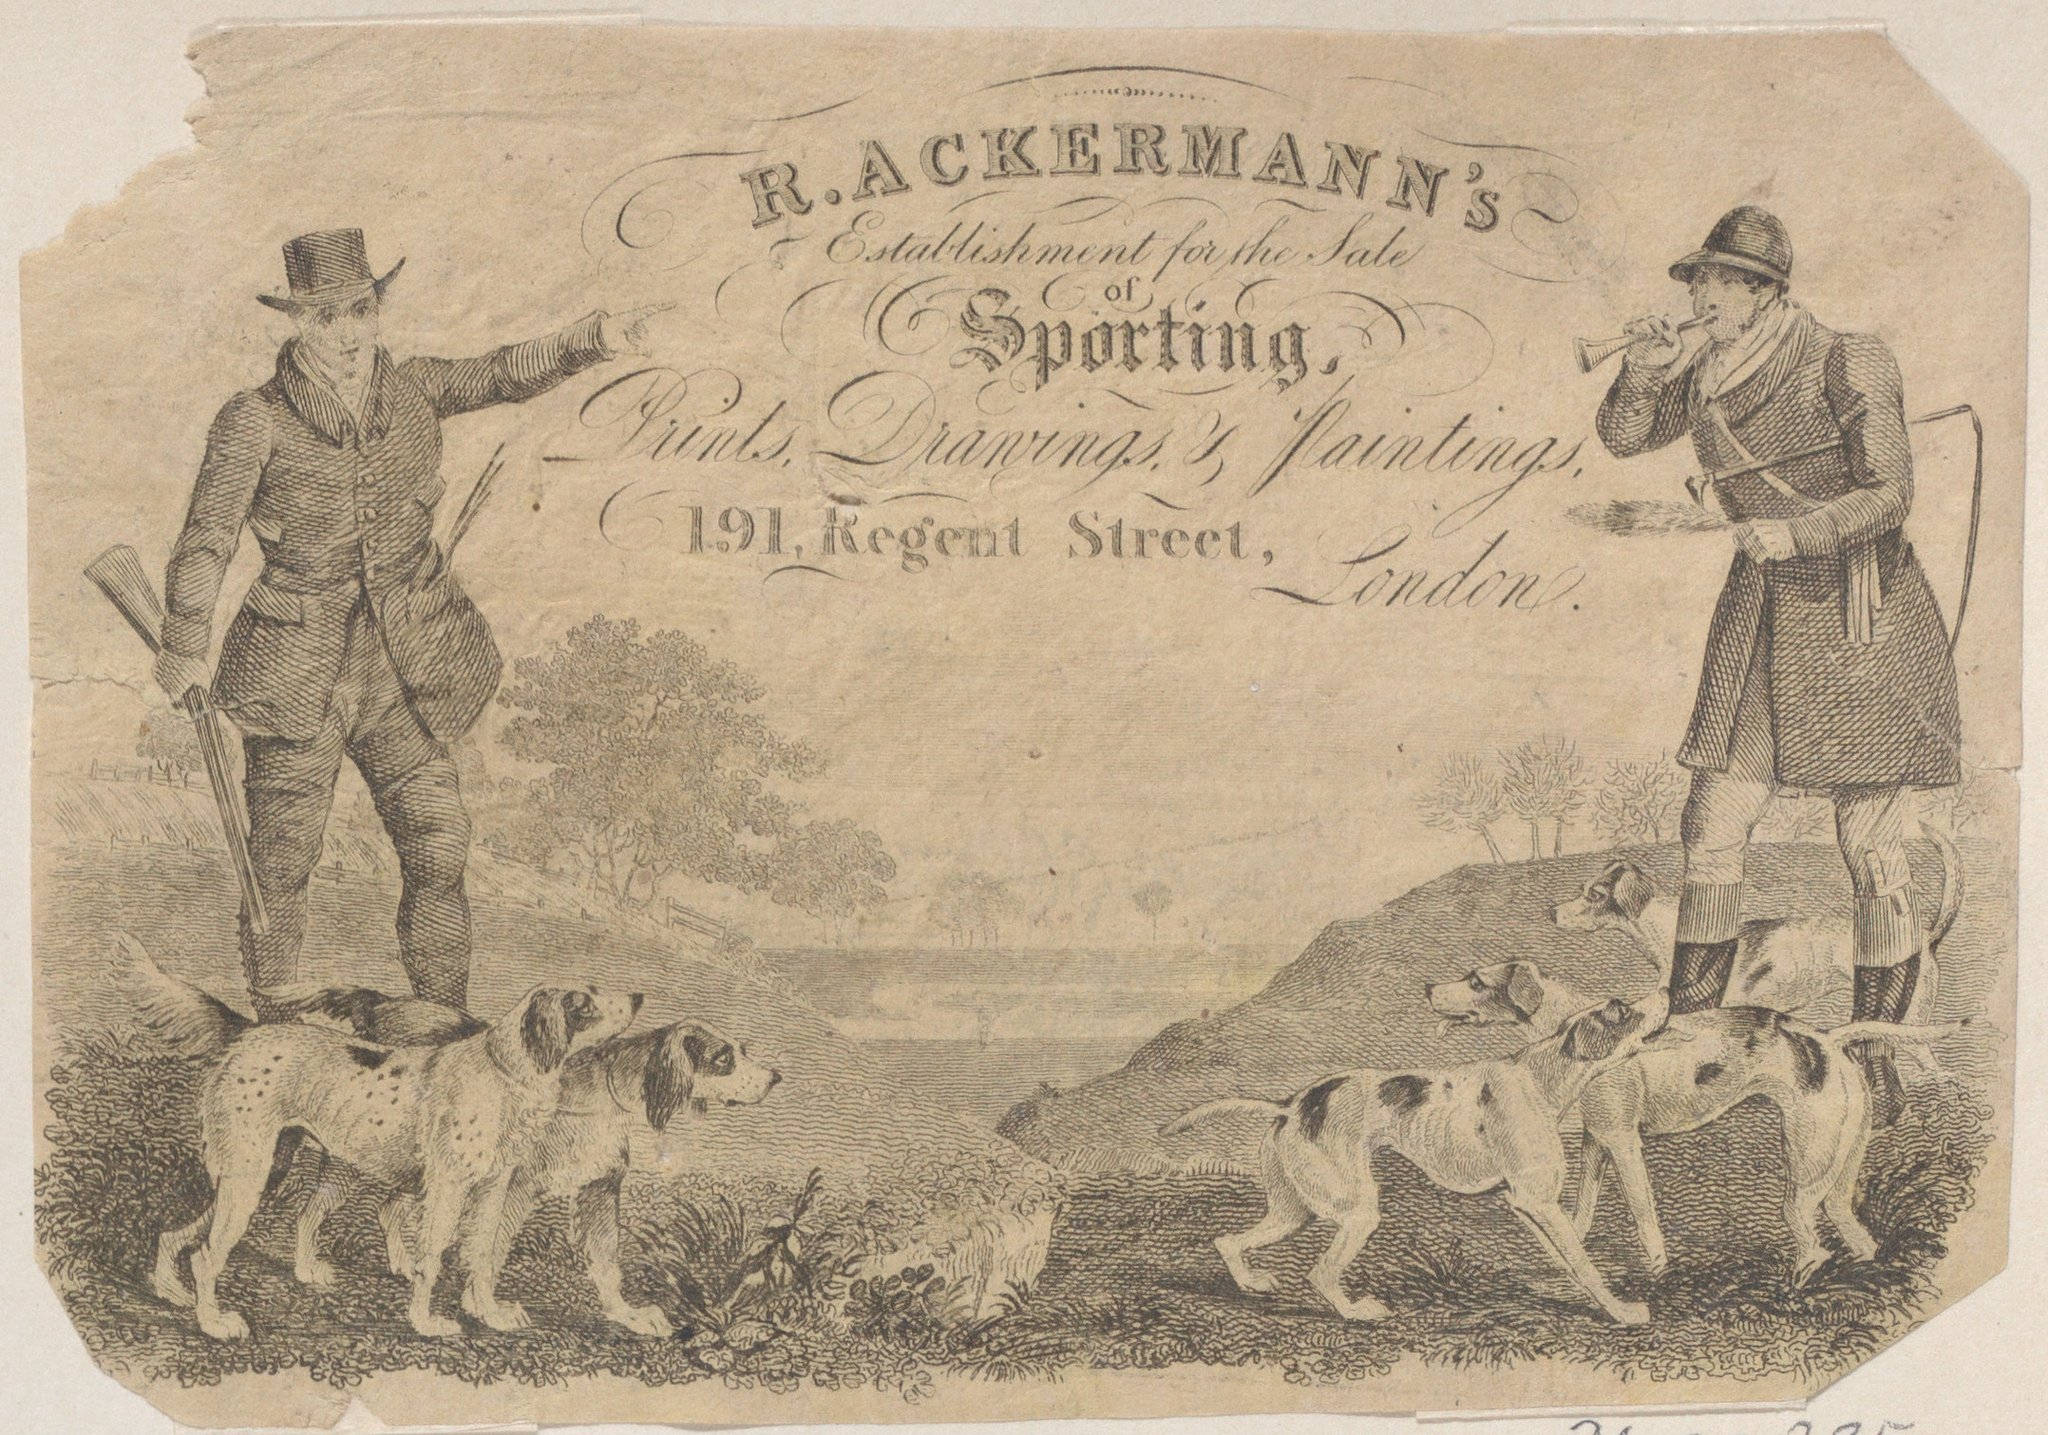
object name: print, trade card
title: Trade Card for R. Ackermann, Printseller and Art Dealer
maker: anonymous, british, 19th century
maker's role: artist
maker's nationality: british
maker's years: 1800-1900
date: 1801-1900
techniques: engraving